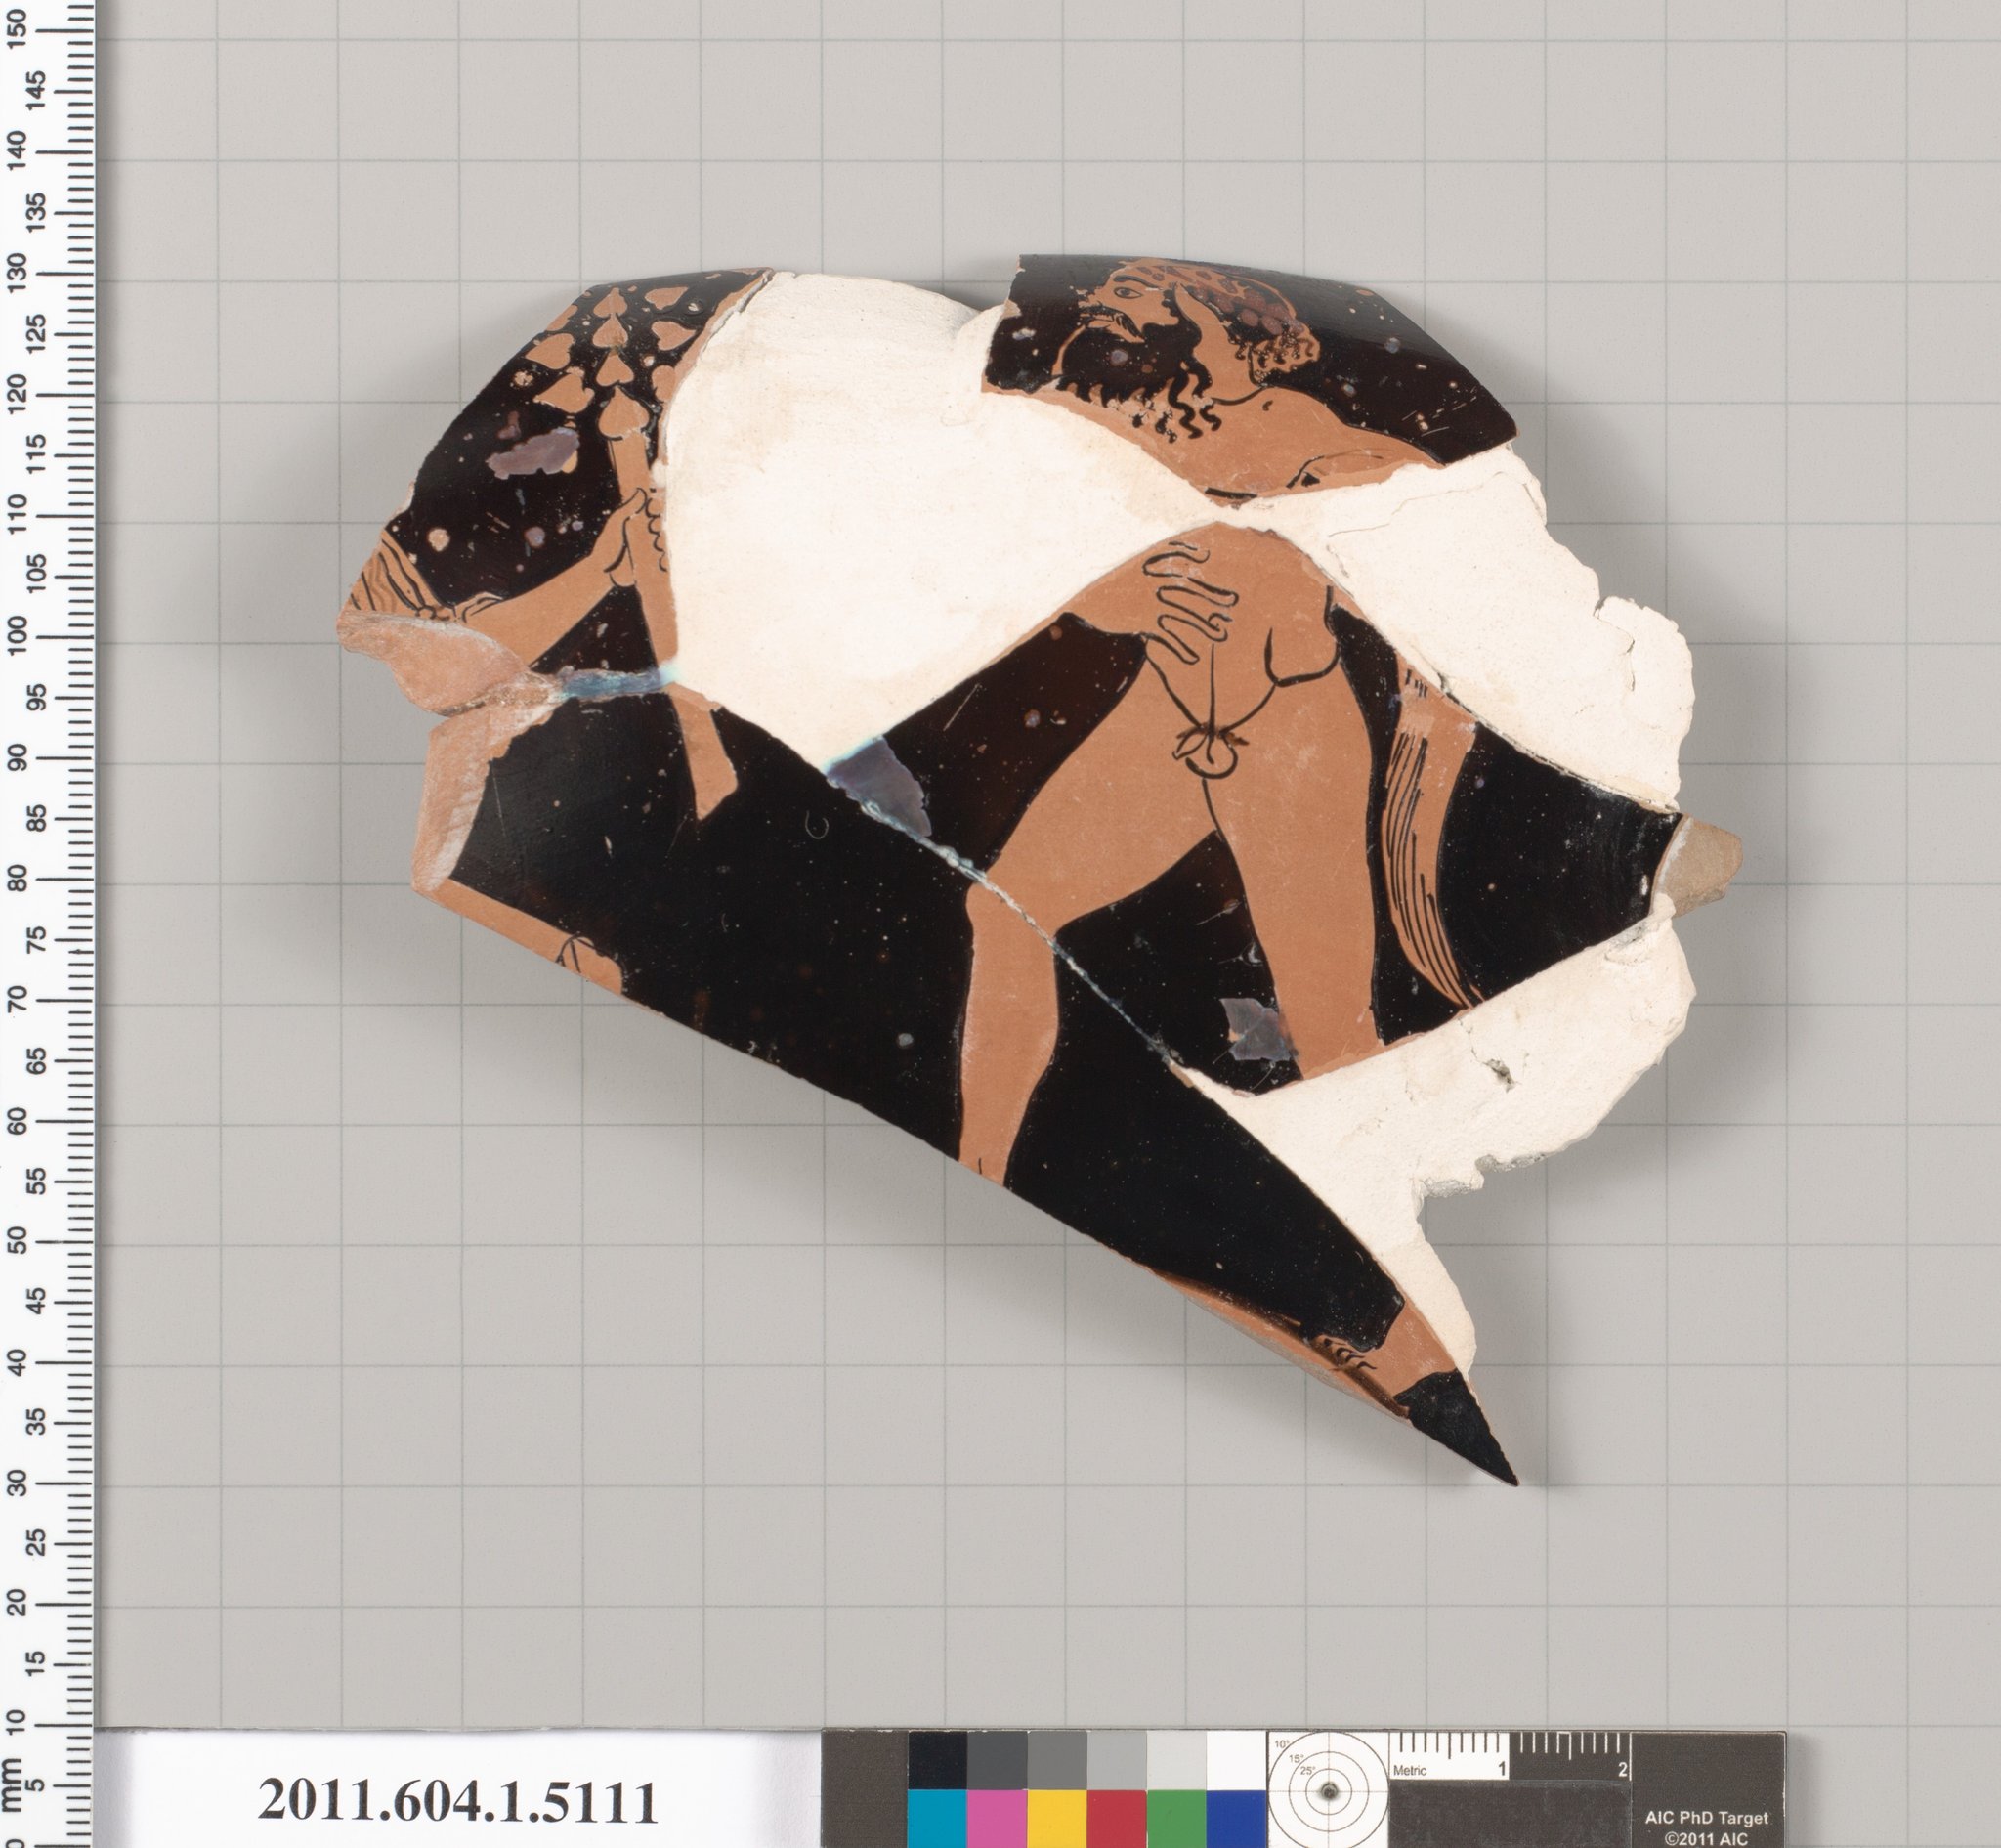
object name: kylix fragment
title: Terracotta rim fragment of a kylix (drinking cup)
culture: greek, attic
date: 500-480 BCE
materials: terracotta